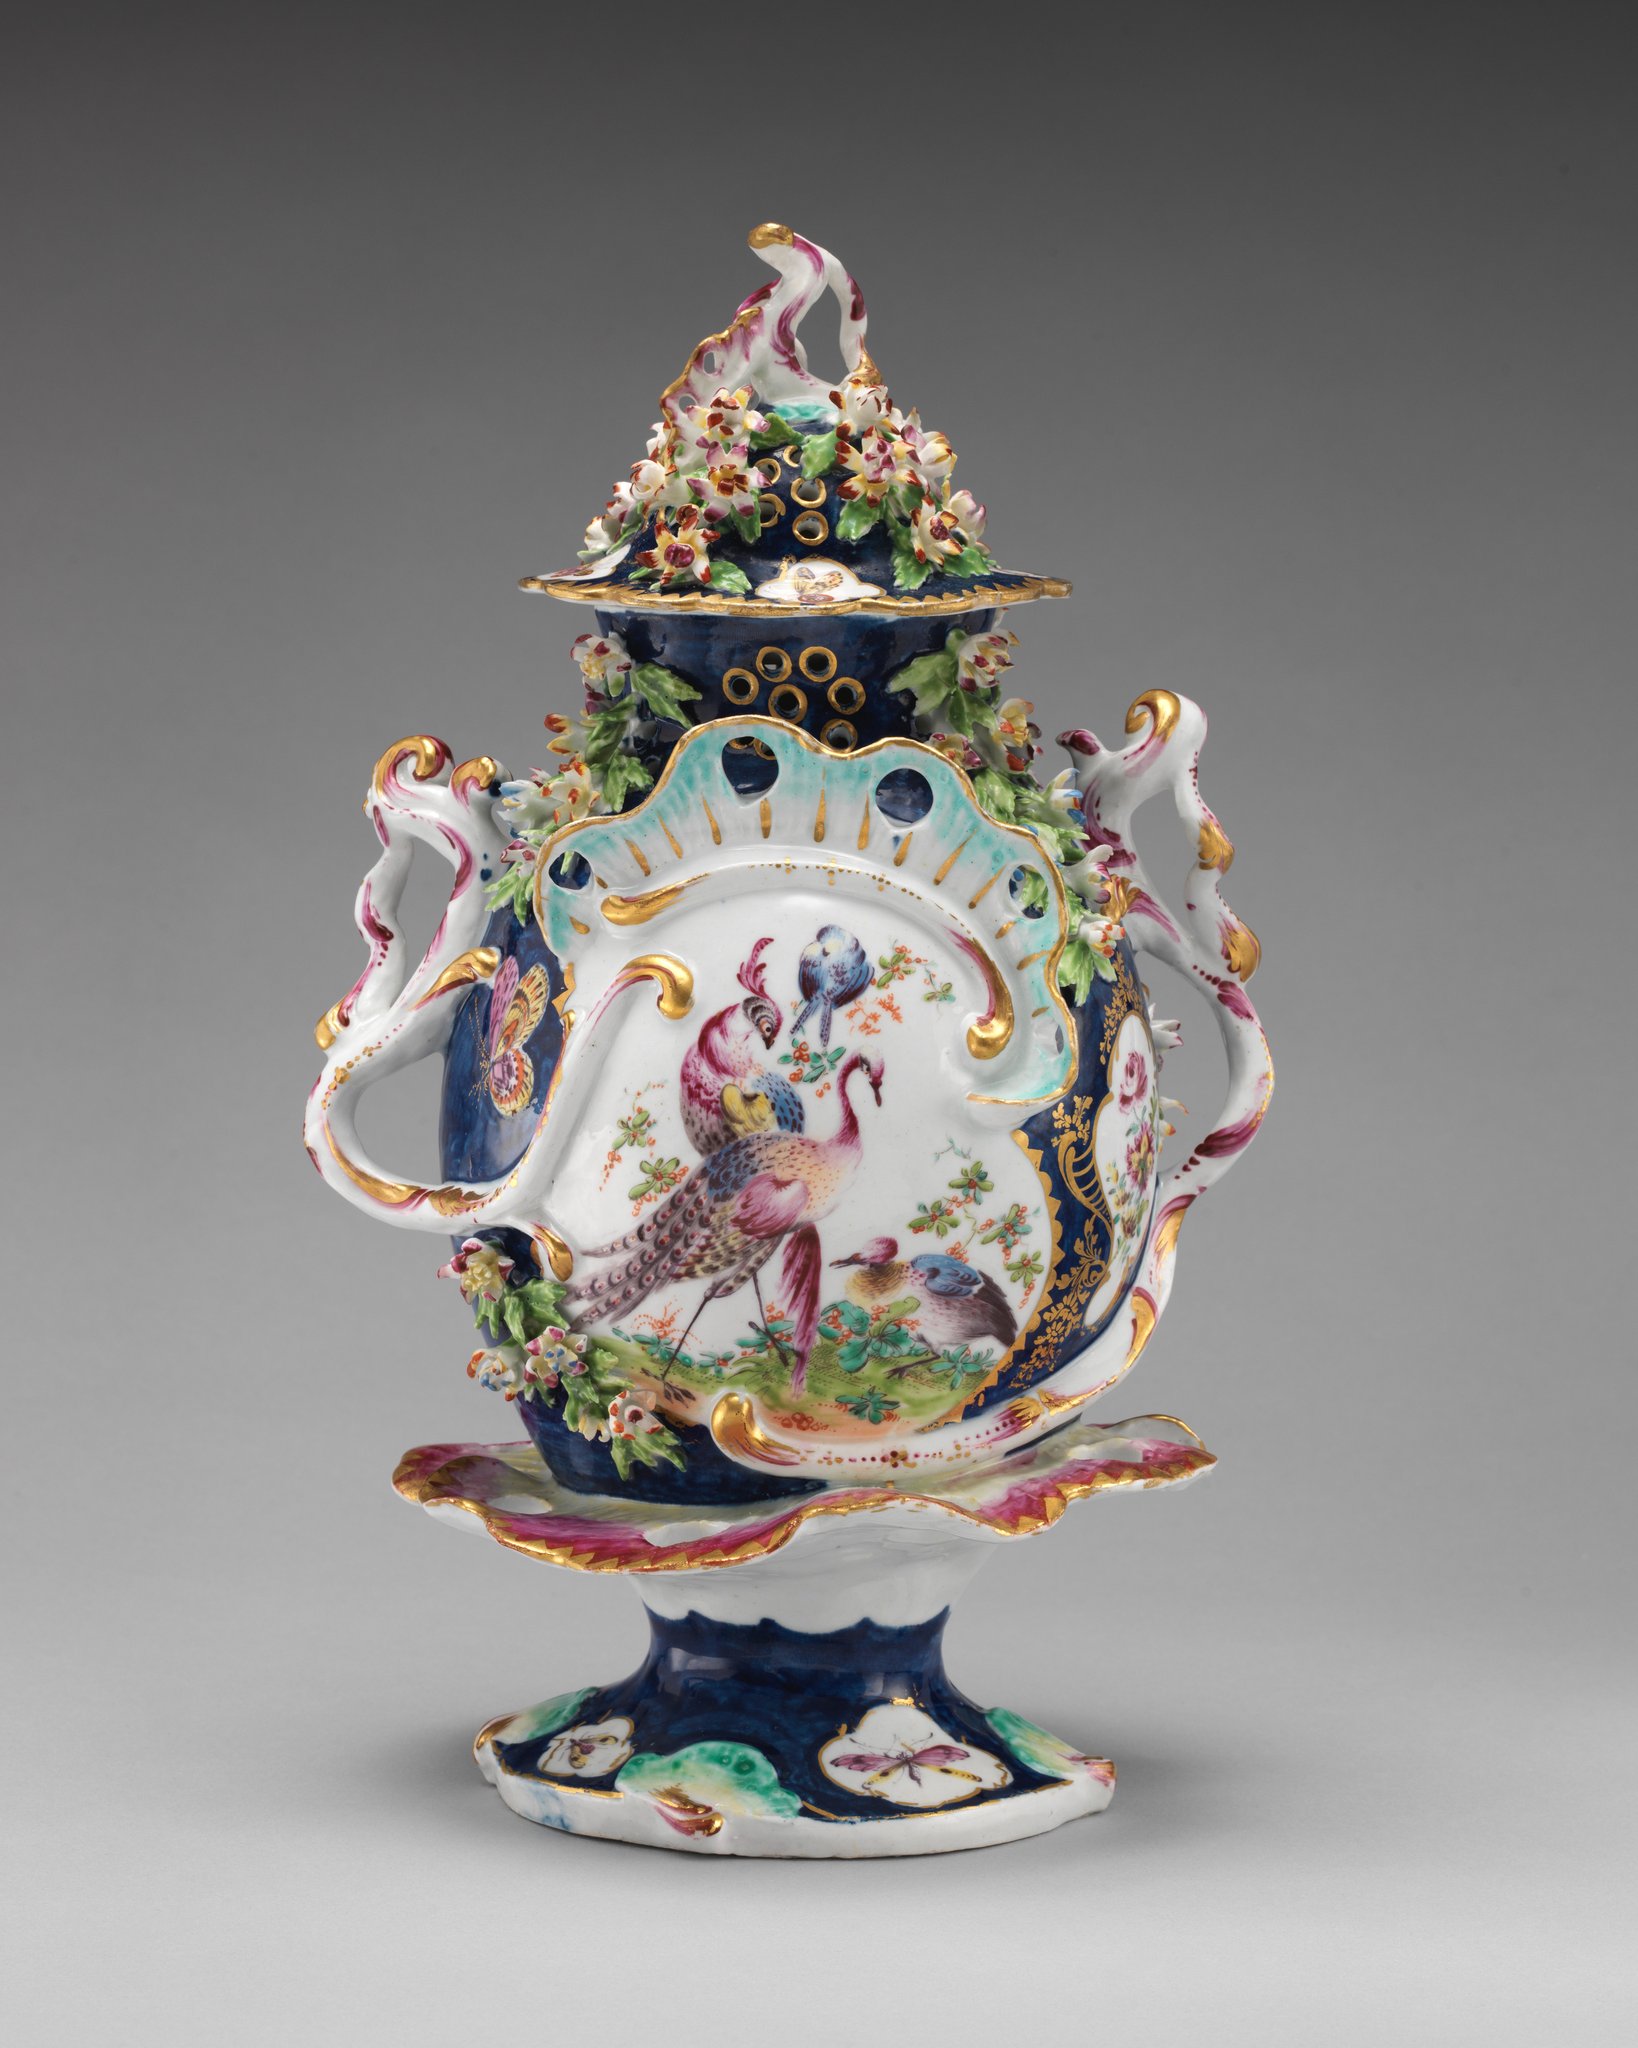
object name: vase with cover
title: Vase with cover (part of a garniture)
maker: bow porcelain factory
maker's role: factory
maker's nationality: british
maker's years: 1747-1776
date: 1765-1770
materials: soft paste porcelain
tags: birds,flowers